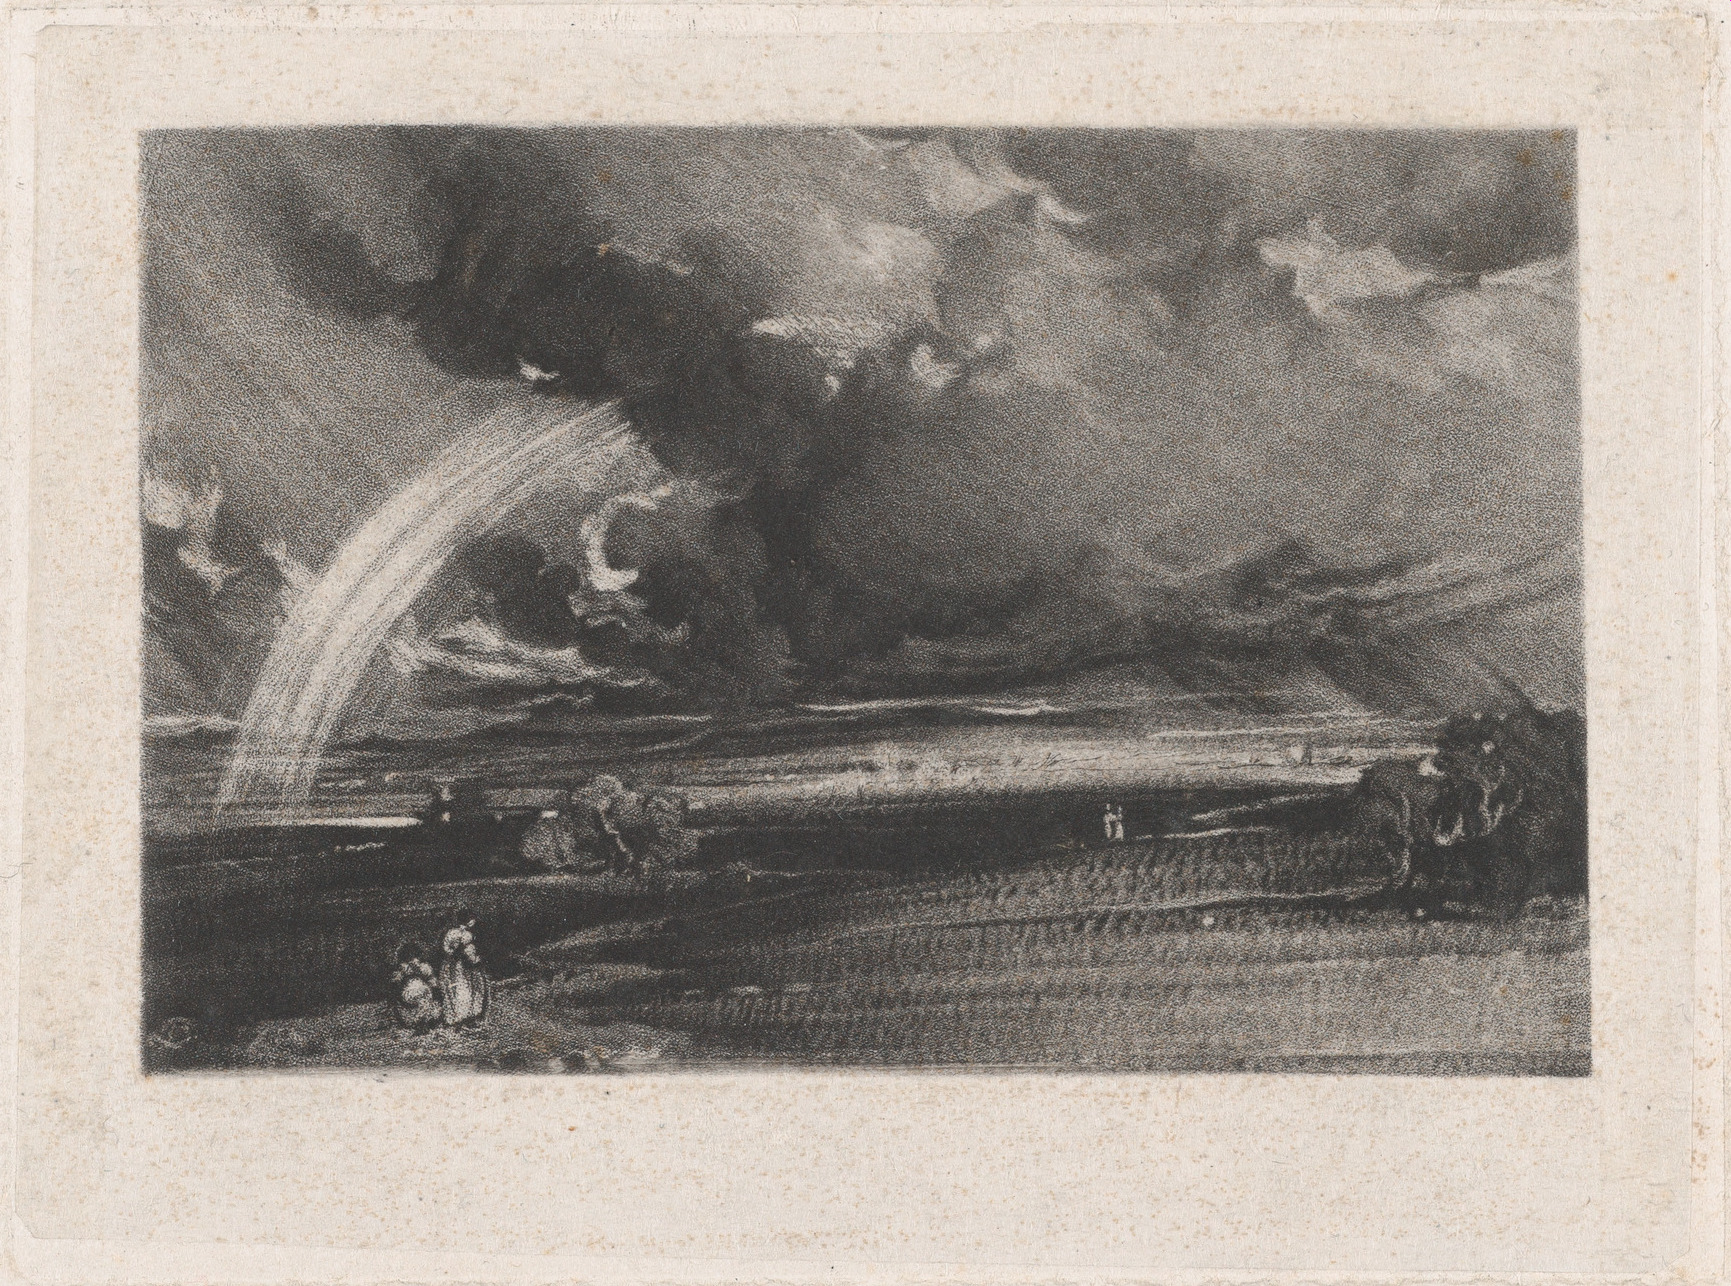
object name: print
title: Departing Storm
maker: david lucas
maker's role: artist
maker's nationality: british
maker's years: 1802-1881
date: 1829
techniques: printmaking, mezzotint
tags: women,landscapes,storms